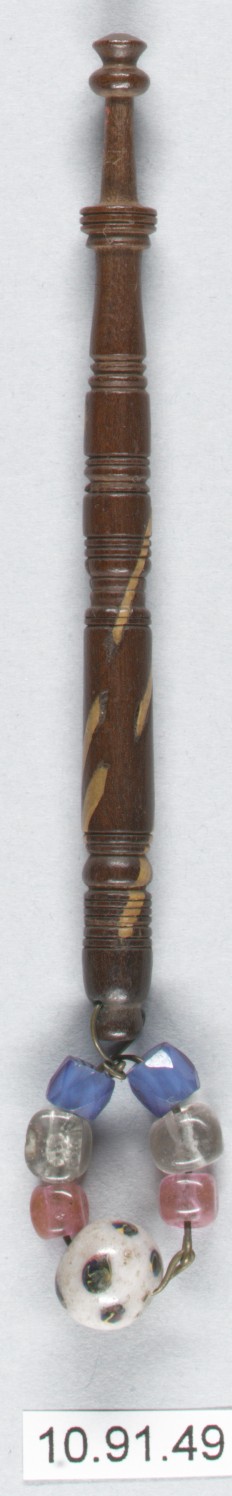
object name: bobbin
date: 1801-1900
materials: wood